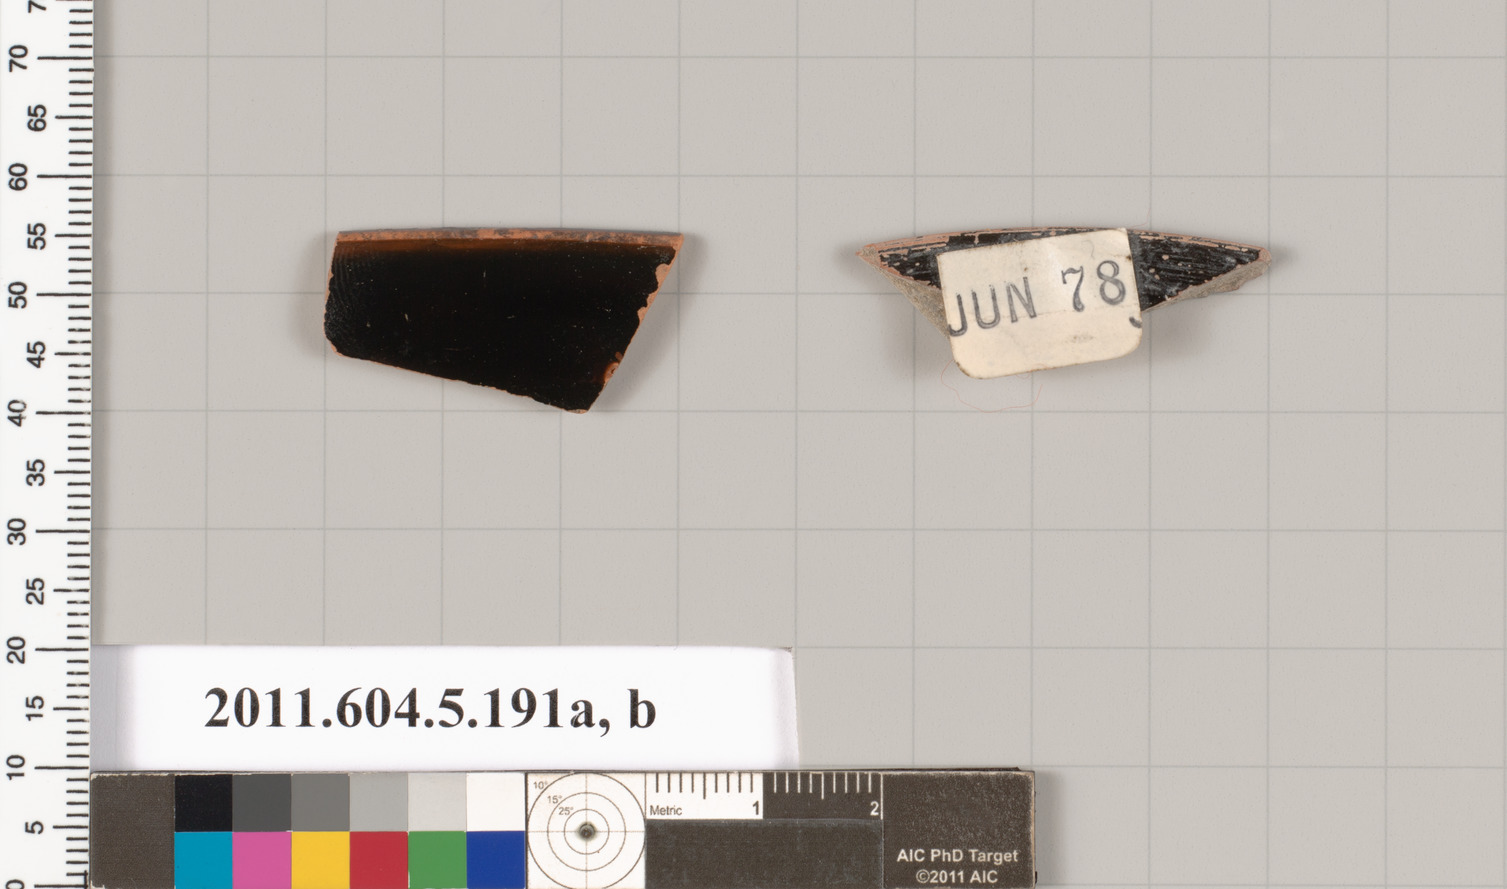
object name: kylix fragment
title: Terracotta rim fragments of kylikes (drinking cups)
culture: greek, attic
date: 600-401 BCE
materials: terracotta